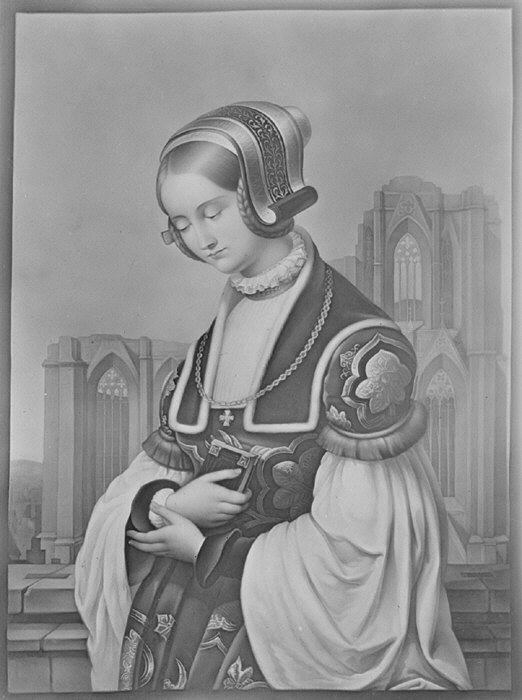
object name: lithophane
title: Going to Church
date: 1834-1866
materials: porcelain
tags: women